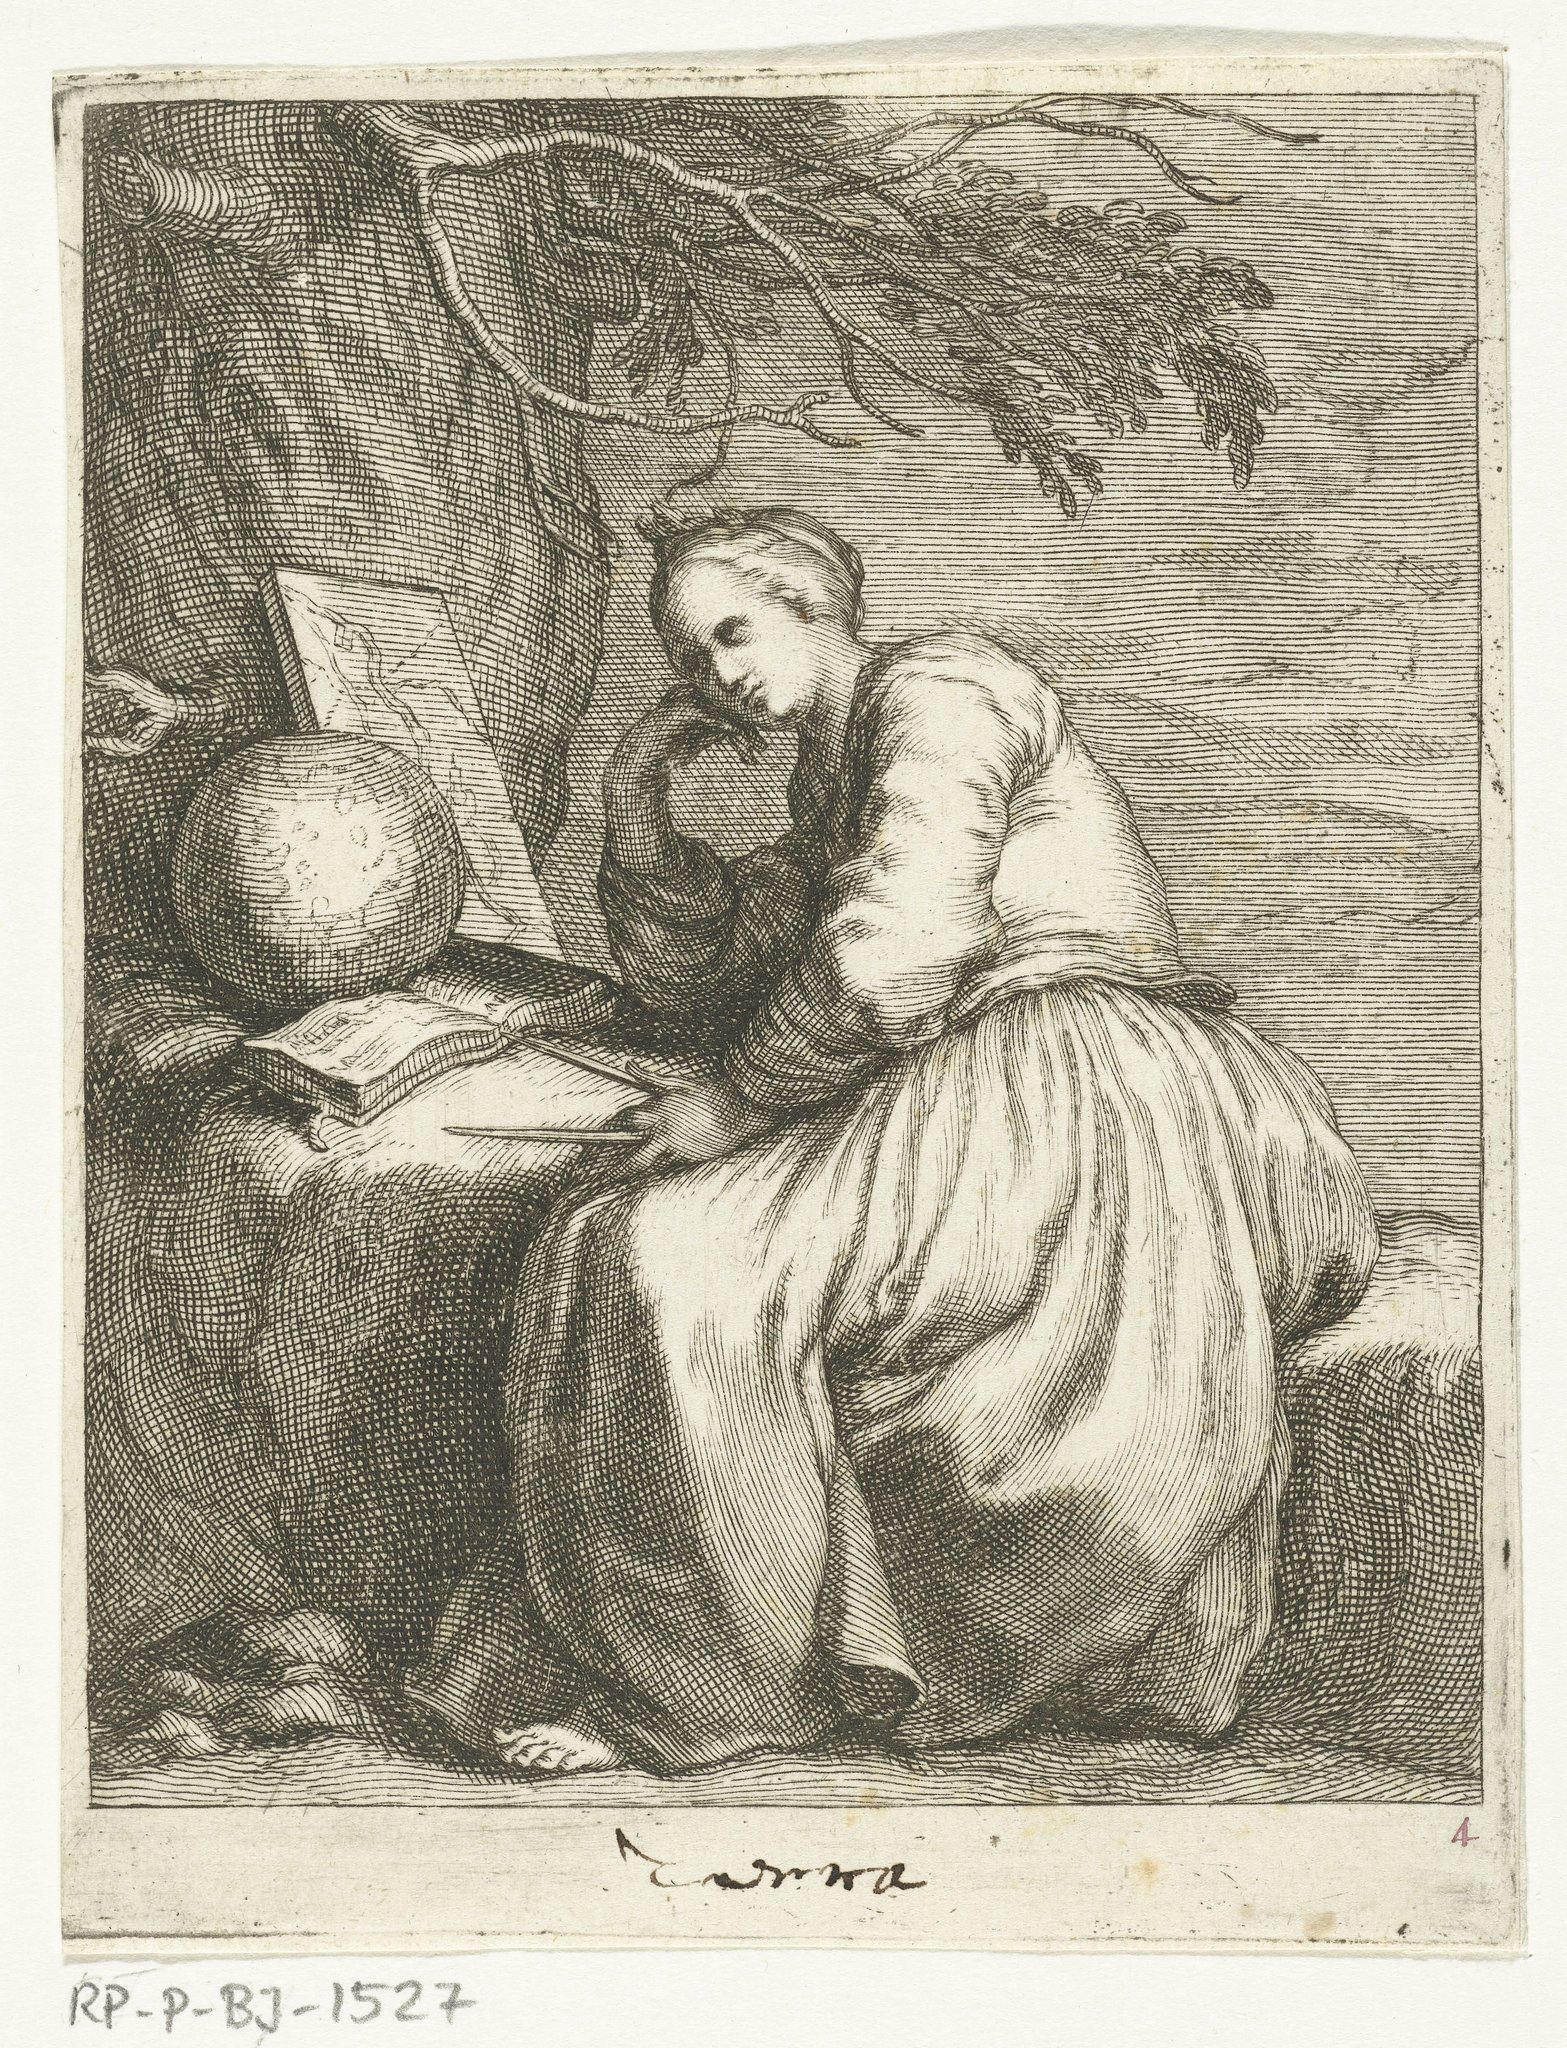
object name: print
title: Aarde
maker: frederick bloemaert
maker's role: print maker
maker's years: 1614-1669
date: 1632-1670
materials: paper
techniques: engraving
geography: utrecht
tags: 'geografia', earth (one of the four elements), 'corografia', 'geografia', 'hidrografia' (ripa), compass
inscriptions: collector's mark: Lugt 240, number: ‘4’, inscription: ‘Terra’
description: Zittende vrouwenfiguur als 'Geografie', met haar attributen zoals een kompas, een boek, een globe en een kaart.